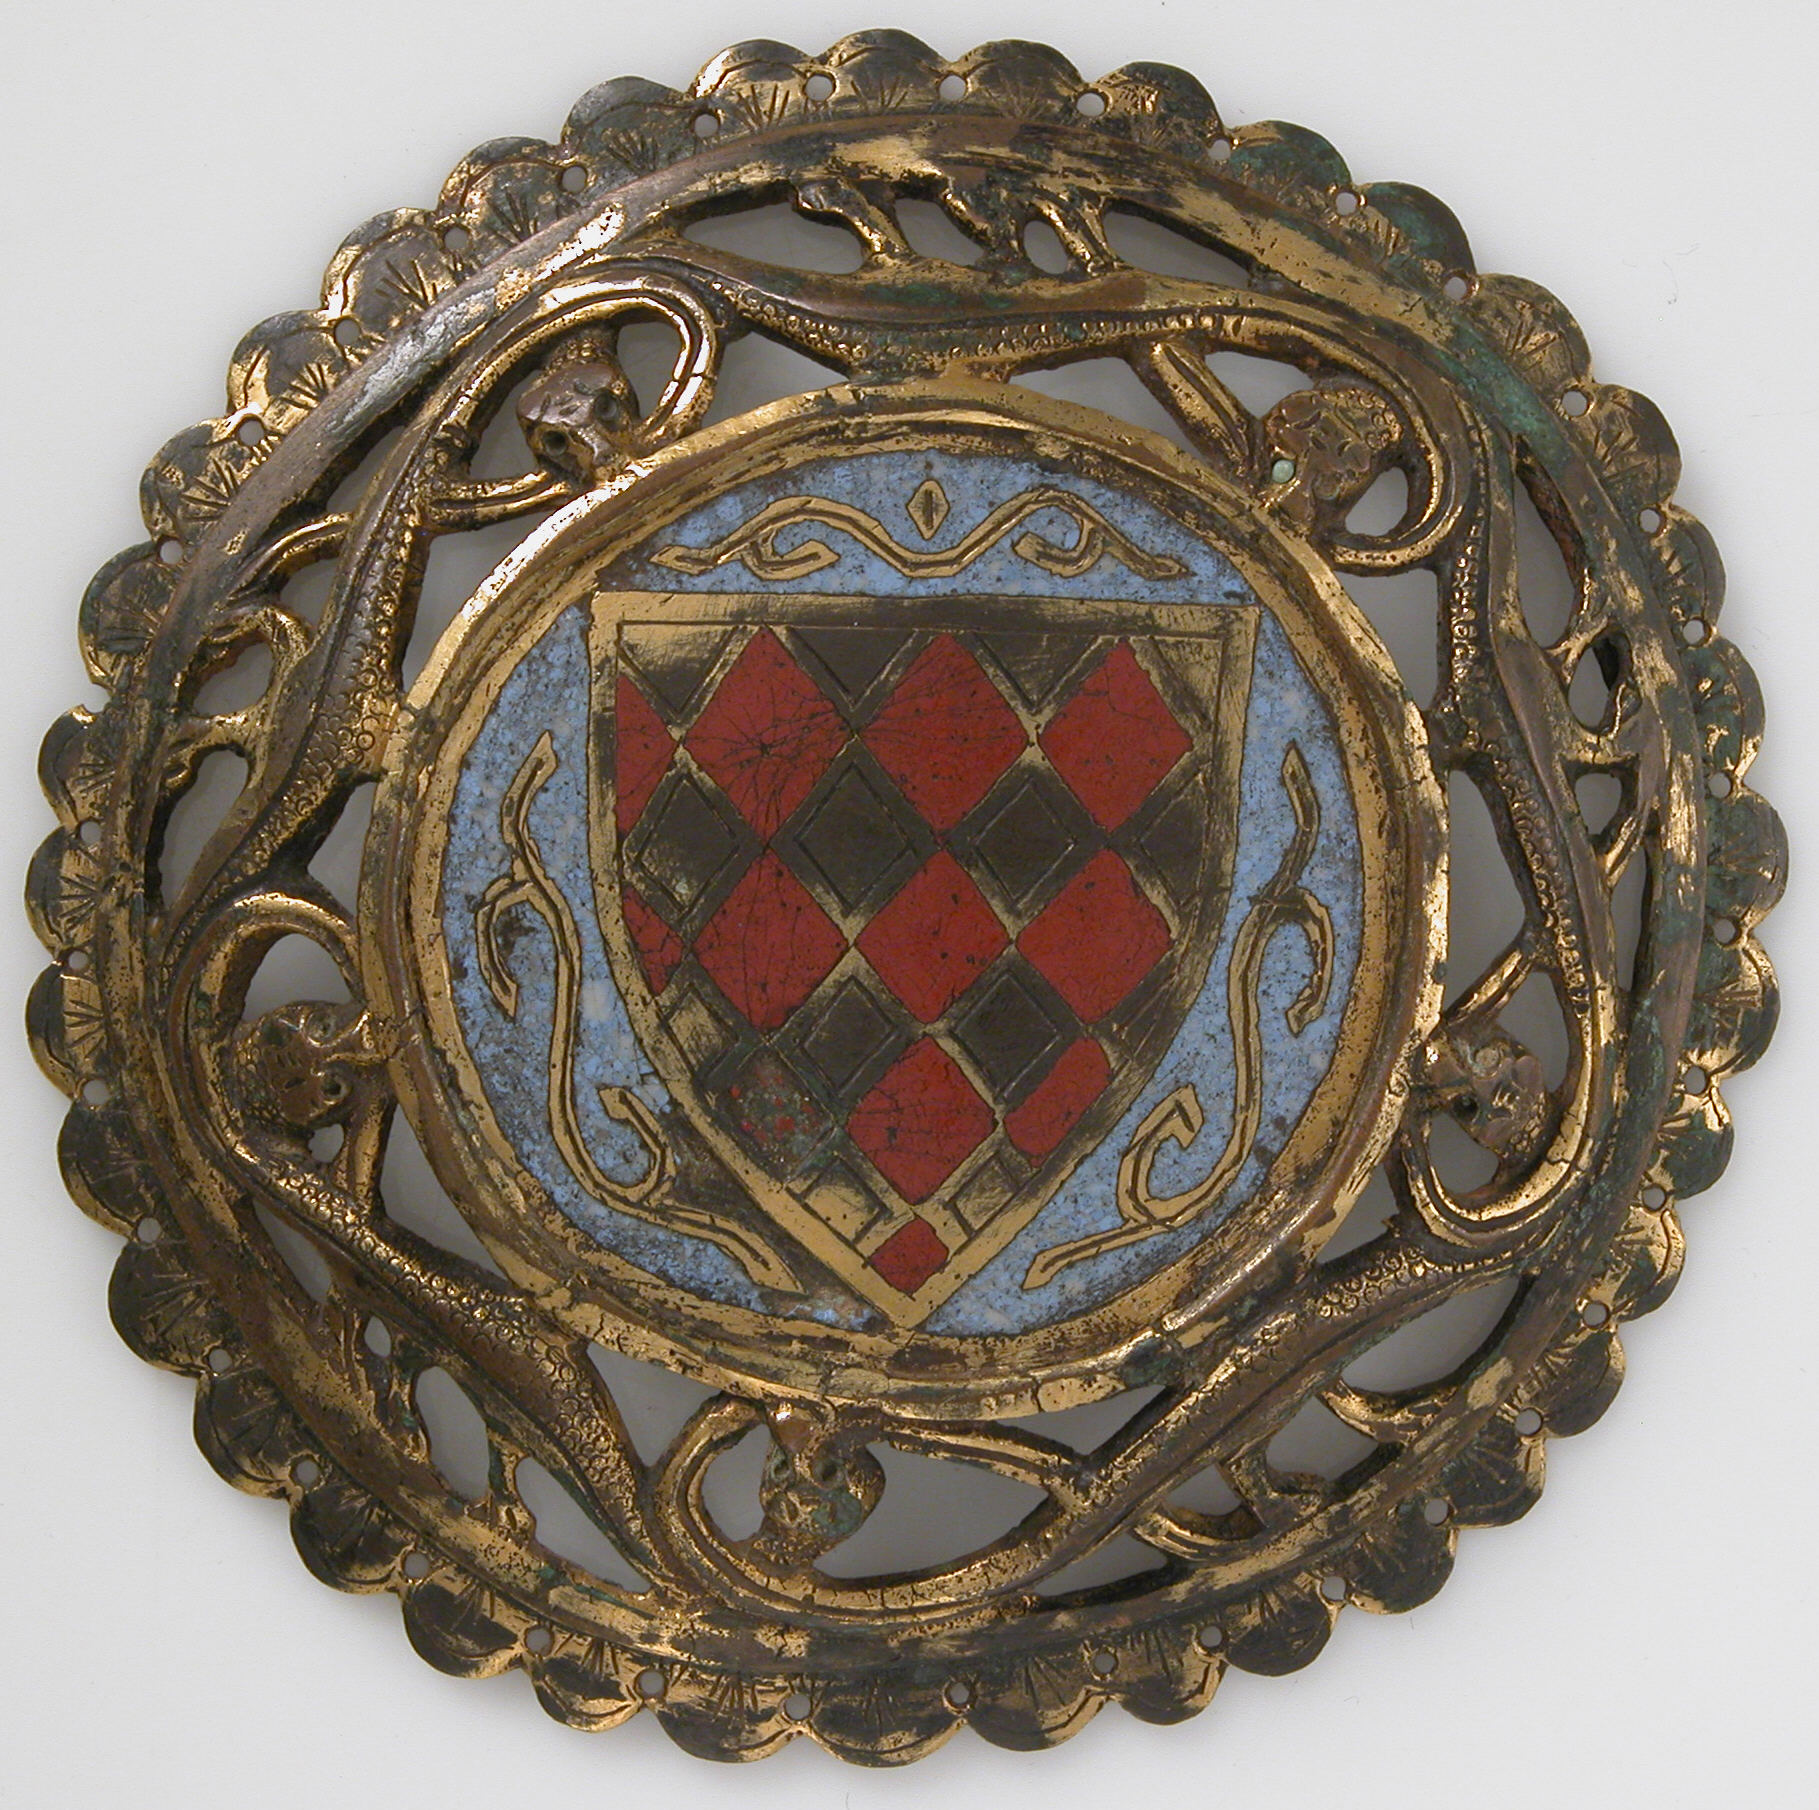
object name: roundel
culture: french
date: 1301-1400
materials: gilt copper, enamel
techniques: enamel